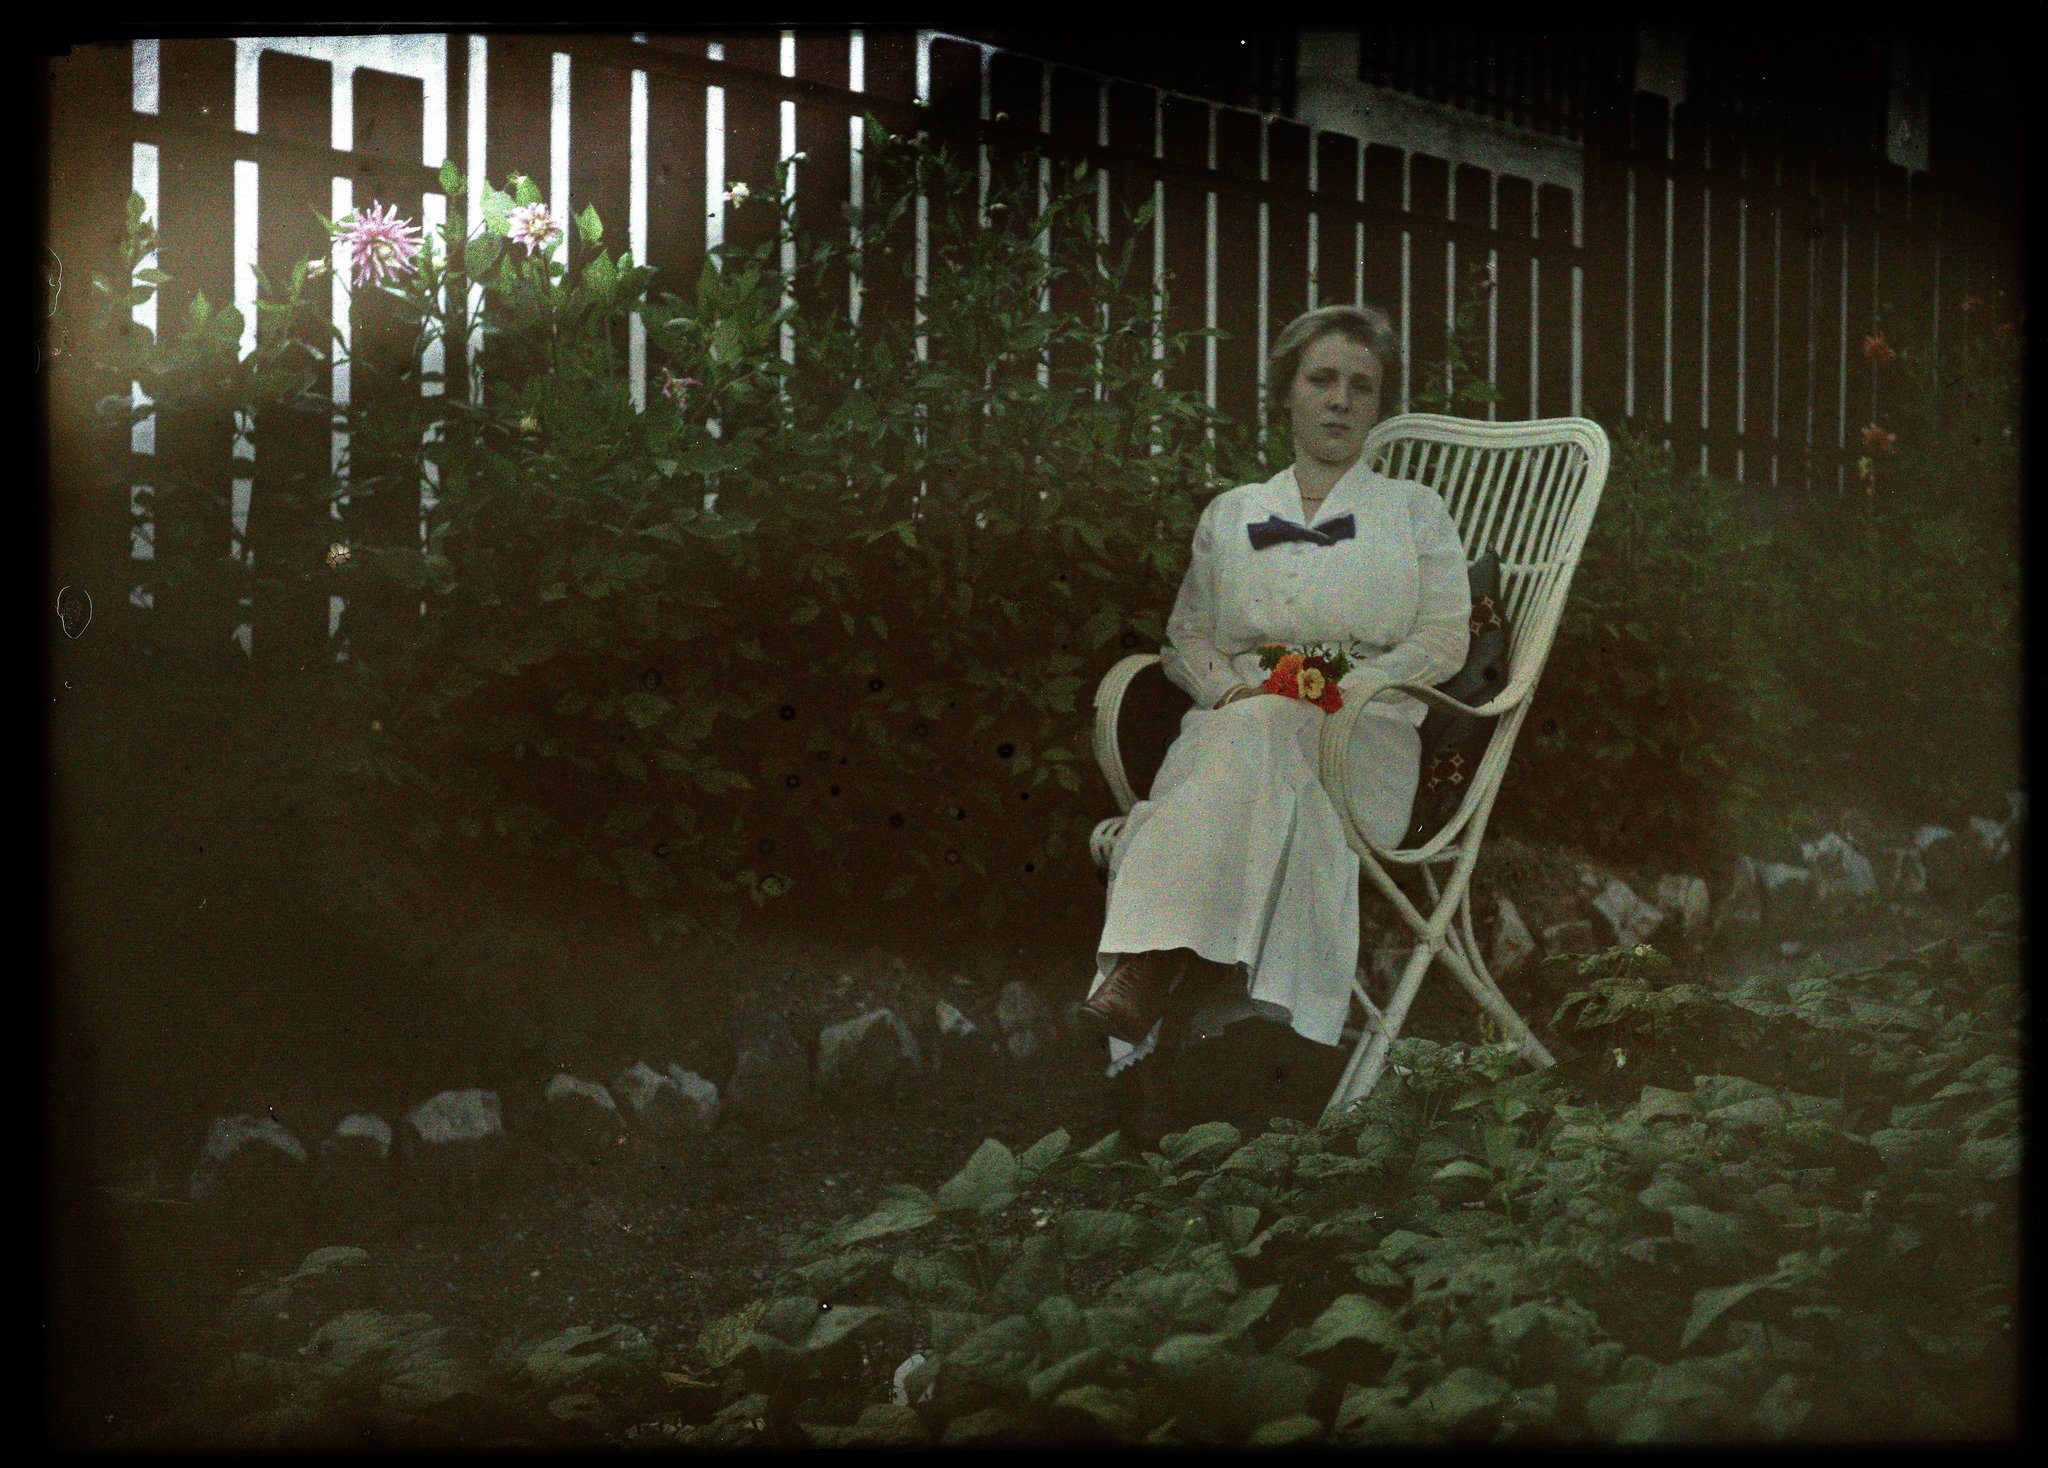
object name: photograph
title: Vrouw zittend in tuin bij rozen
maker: Anonymous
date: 1915-1925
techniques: autochrome process, slide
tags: flowers: dahlia